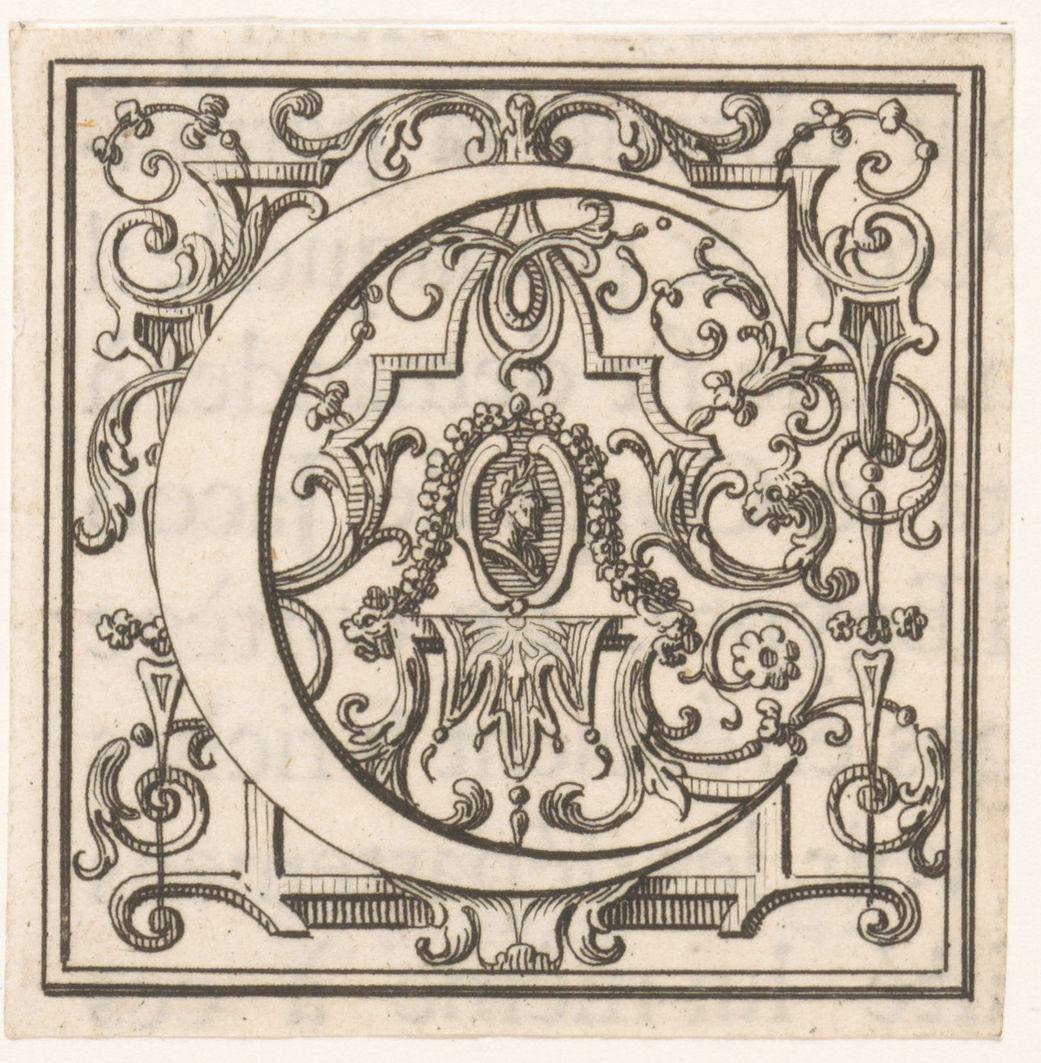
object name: print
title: Letter C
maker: Anonymous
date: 1700-1799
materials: paper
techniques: etching, letterpress printing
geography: france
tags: fancy letters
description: Letter C tegen een achtergrond met vlechtwerk en een portretmedaillon.